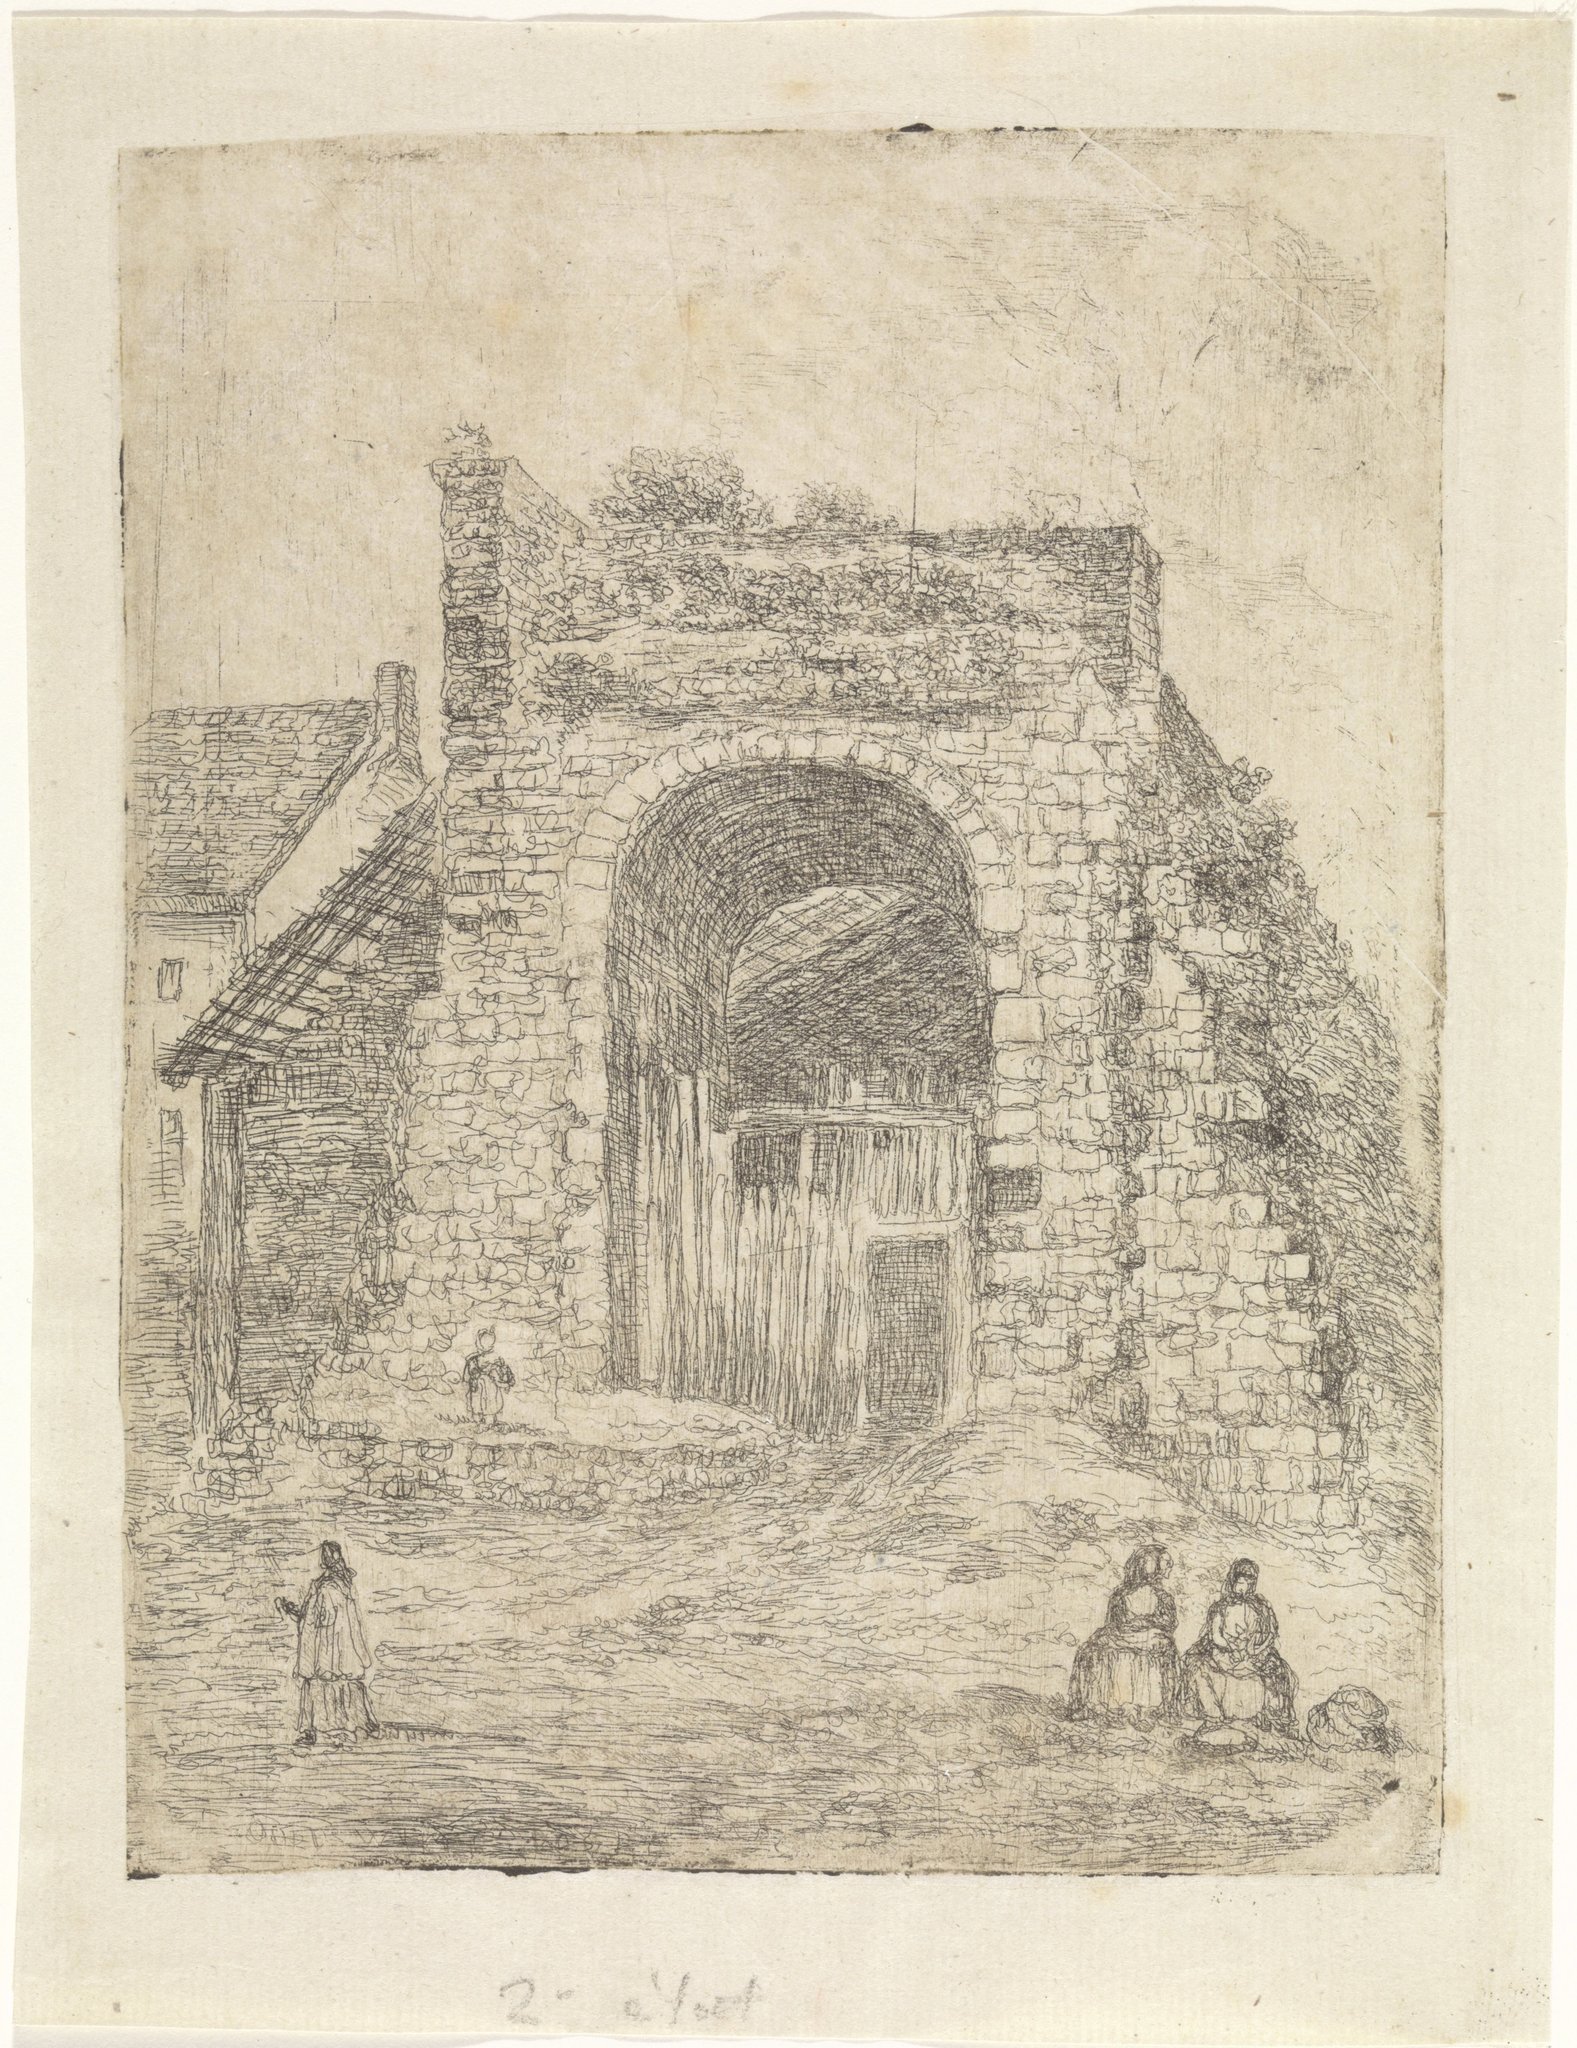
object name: print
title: Ruïne van een poort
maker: alexander schaepkens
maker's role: draughtsman, print maker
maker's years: 1815-1899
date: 1830-1899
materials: paper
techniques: etching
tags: ruin of a building ~ architecture, city-gate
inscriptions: collector's mark: Lugt 2228